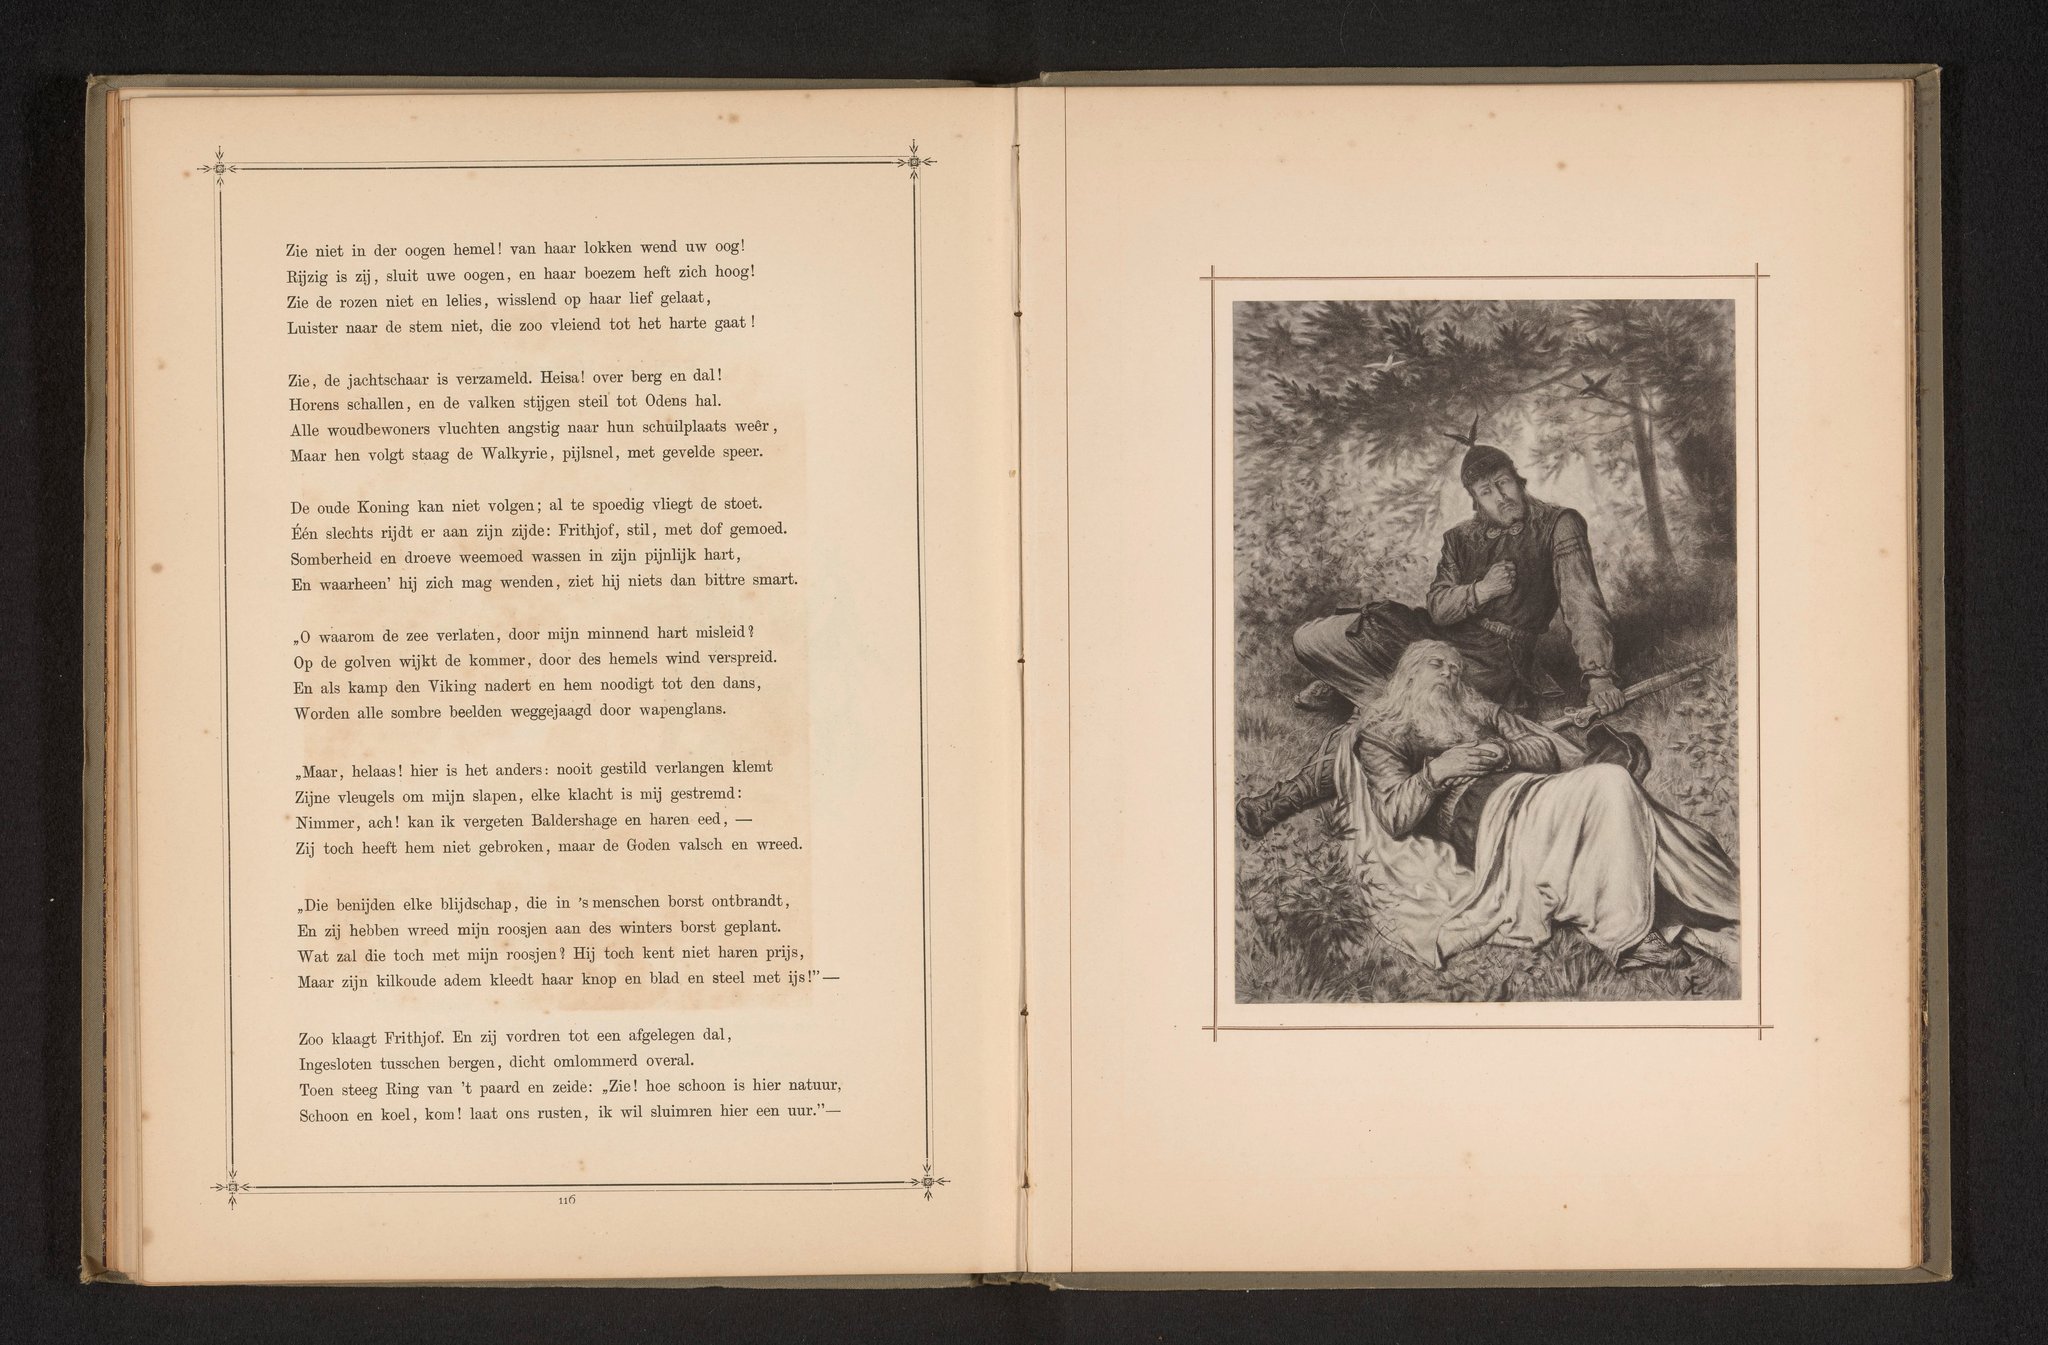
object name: photomechanical print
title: Fotoreproductie van een tekening van Frithjof bij een slapende koning in het bos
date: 1872-1882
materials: paper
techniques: photograph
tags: sleeping; unconsciousness - bb - out of doors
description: Scene uit de Frithiof's Saga door Esaias Tegnér.